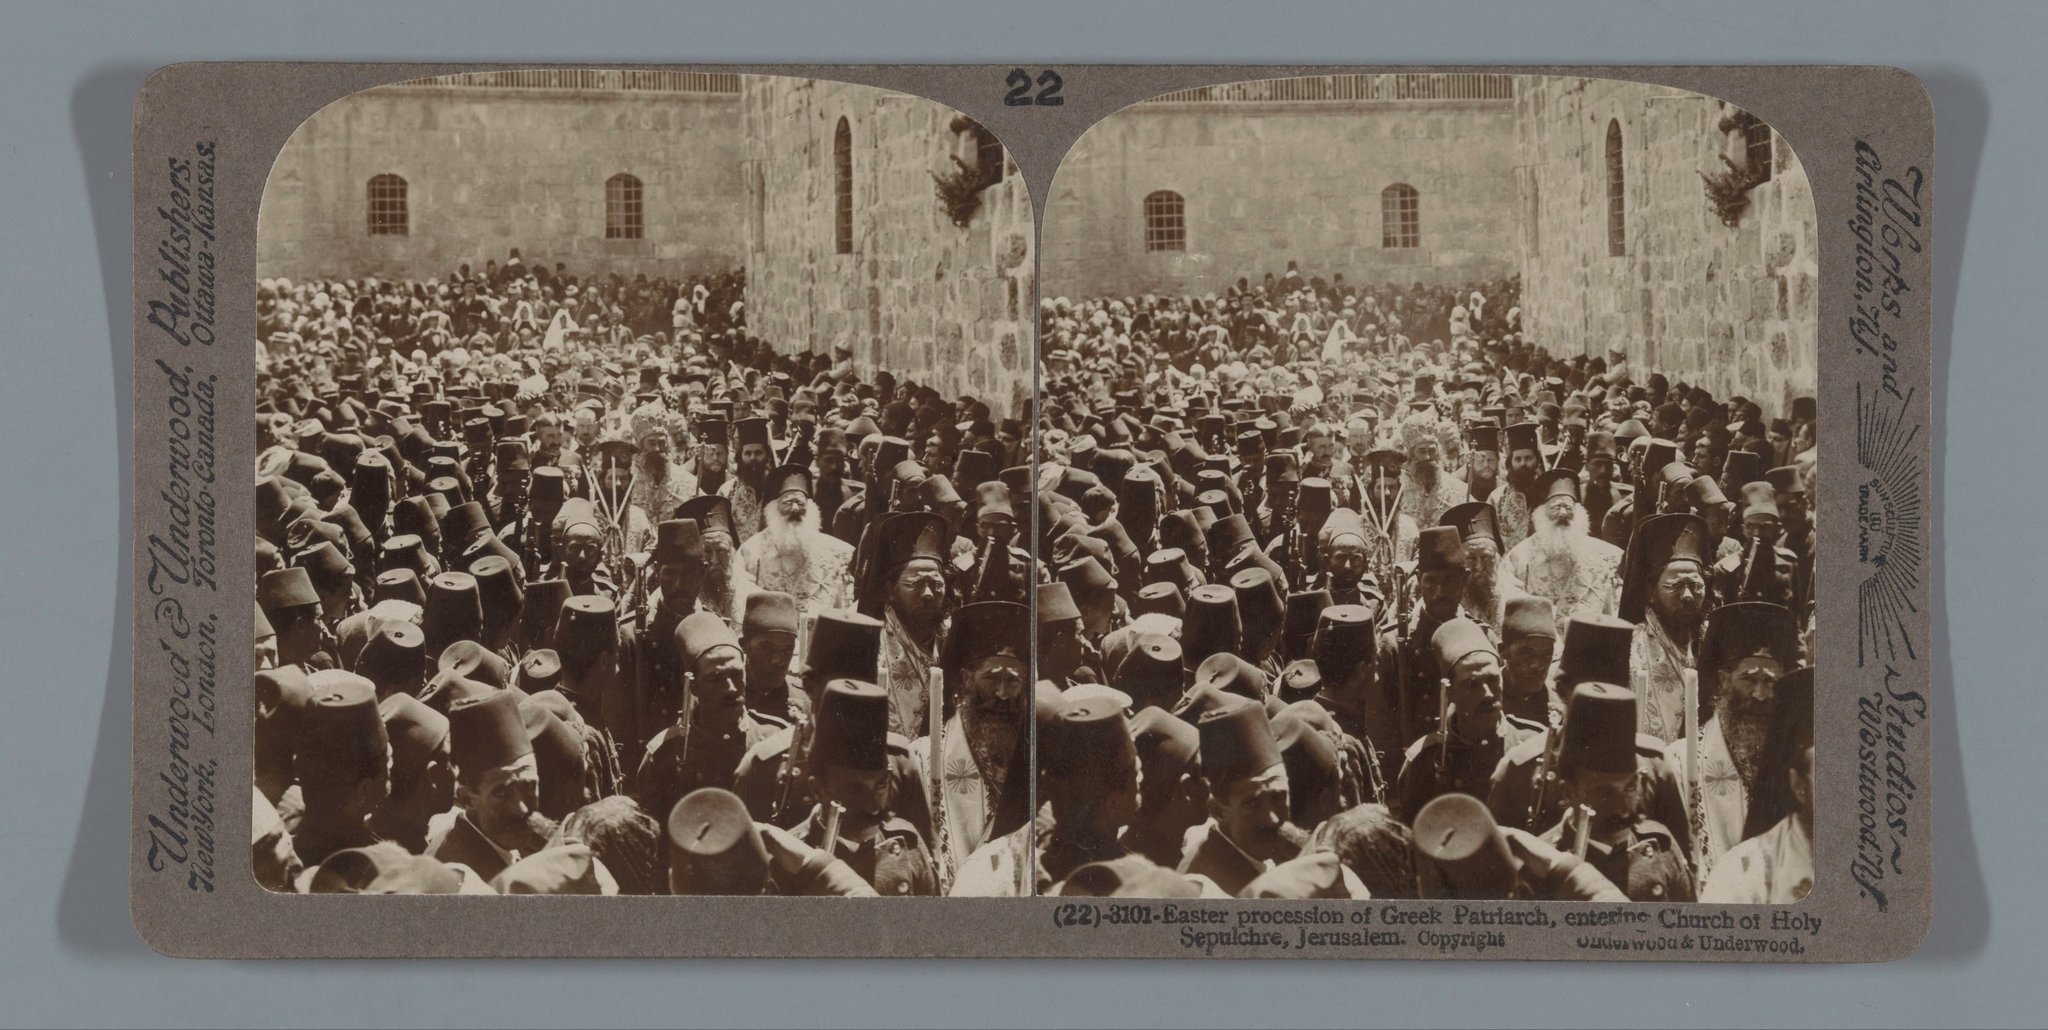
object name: stereograph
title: Easter procession of Greek Patriarch, entering Chruch of Holy Sepulchre, Jerusalem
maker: Anonymous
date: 1900-1905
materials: paper, cardboard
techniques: gelatin silver print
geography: new york city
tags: procession ~ christian religion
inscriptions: inscription: ‘Works and Studios ~/ Arlington, N.J. Westwood, N.J.’, number: ‘(22)-3101-’, inscription, number: ‘22’, copyright notice: ‘Copyright Underwood & Underwood.’